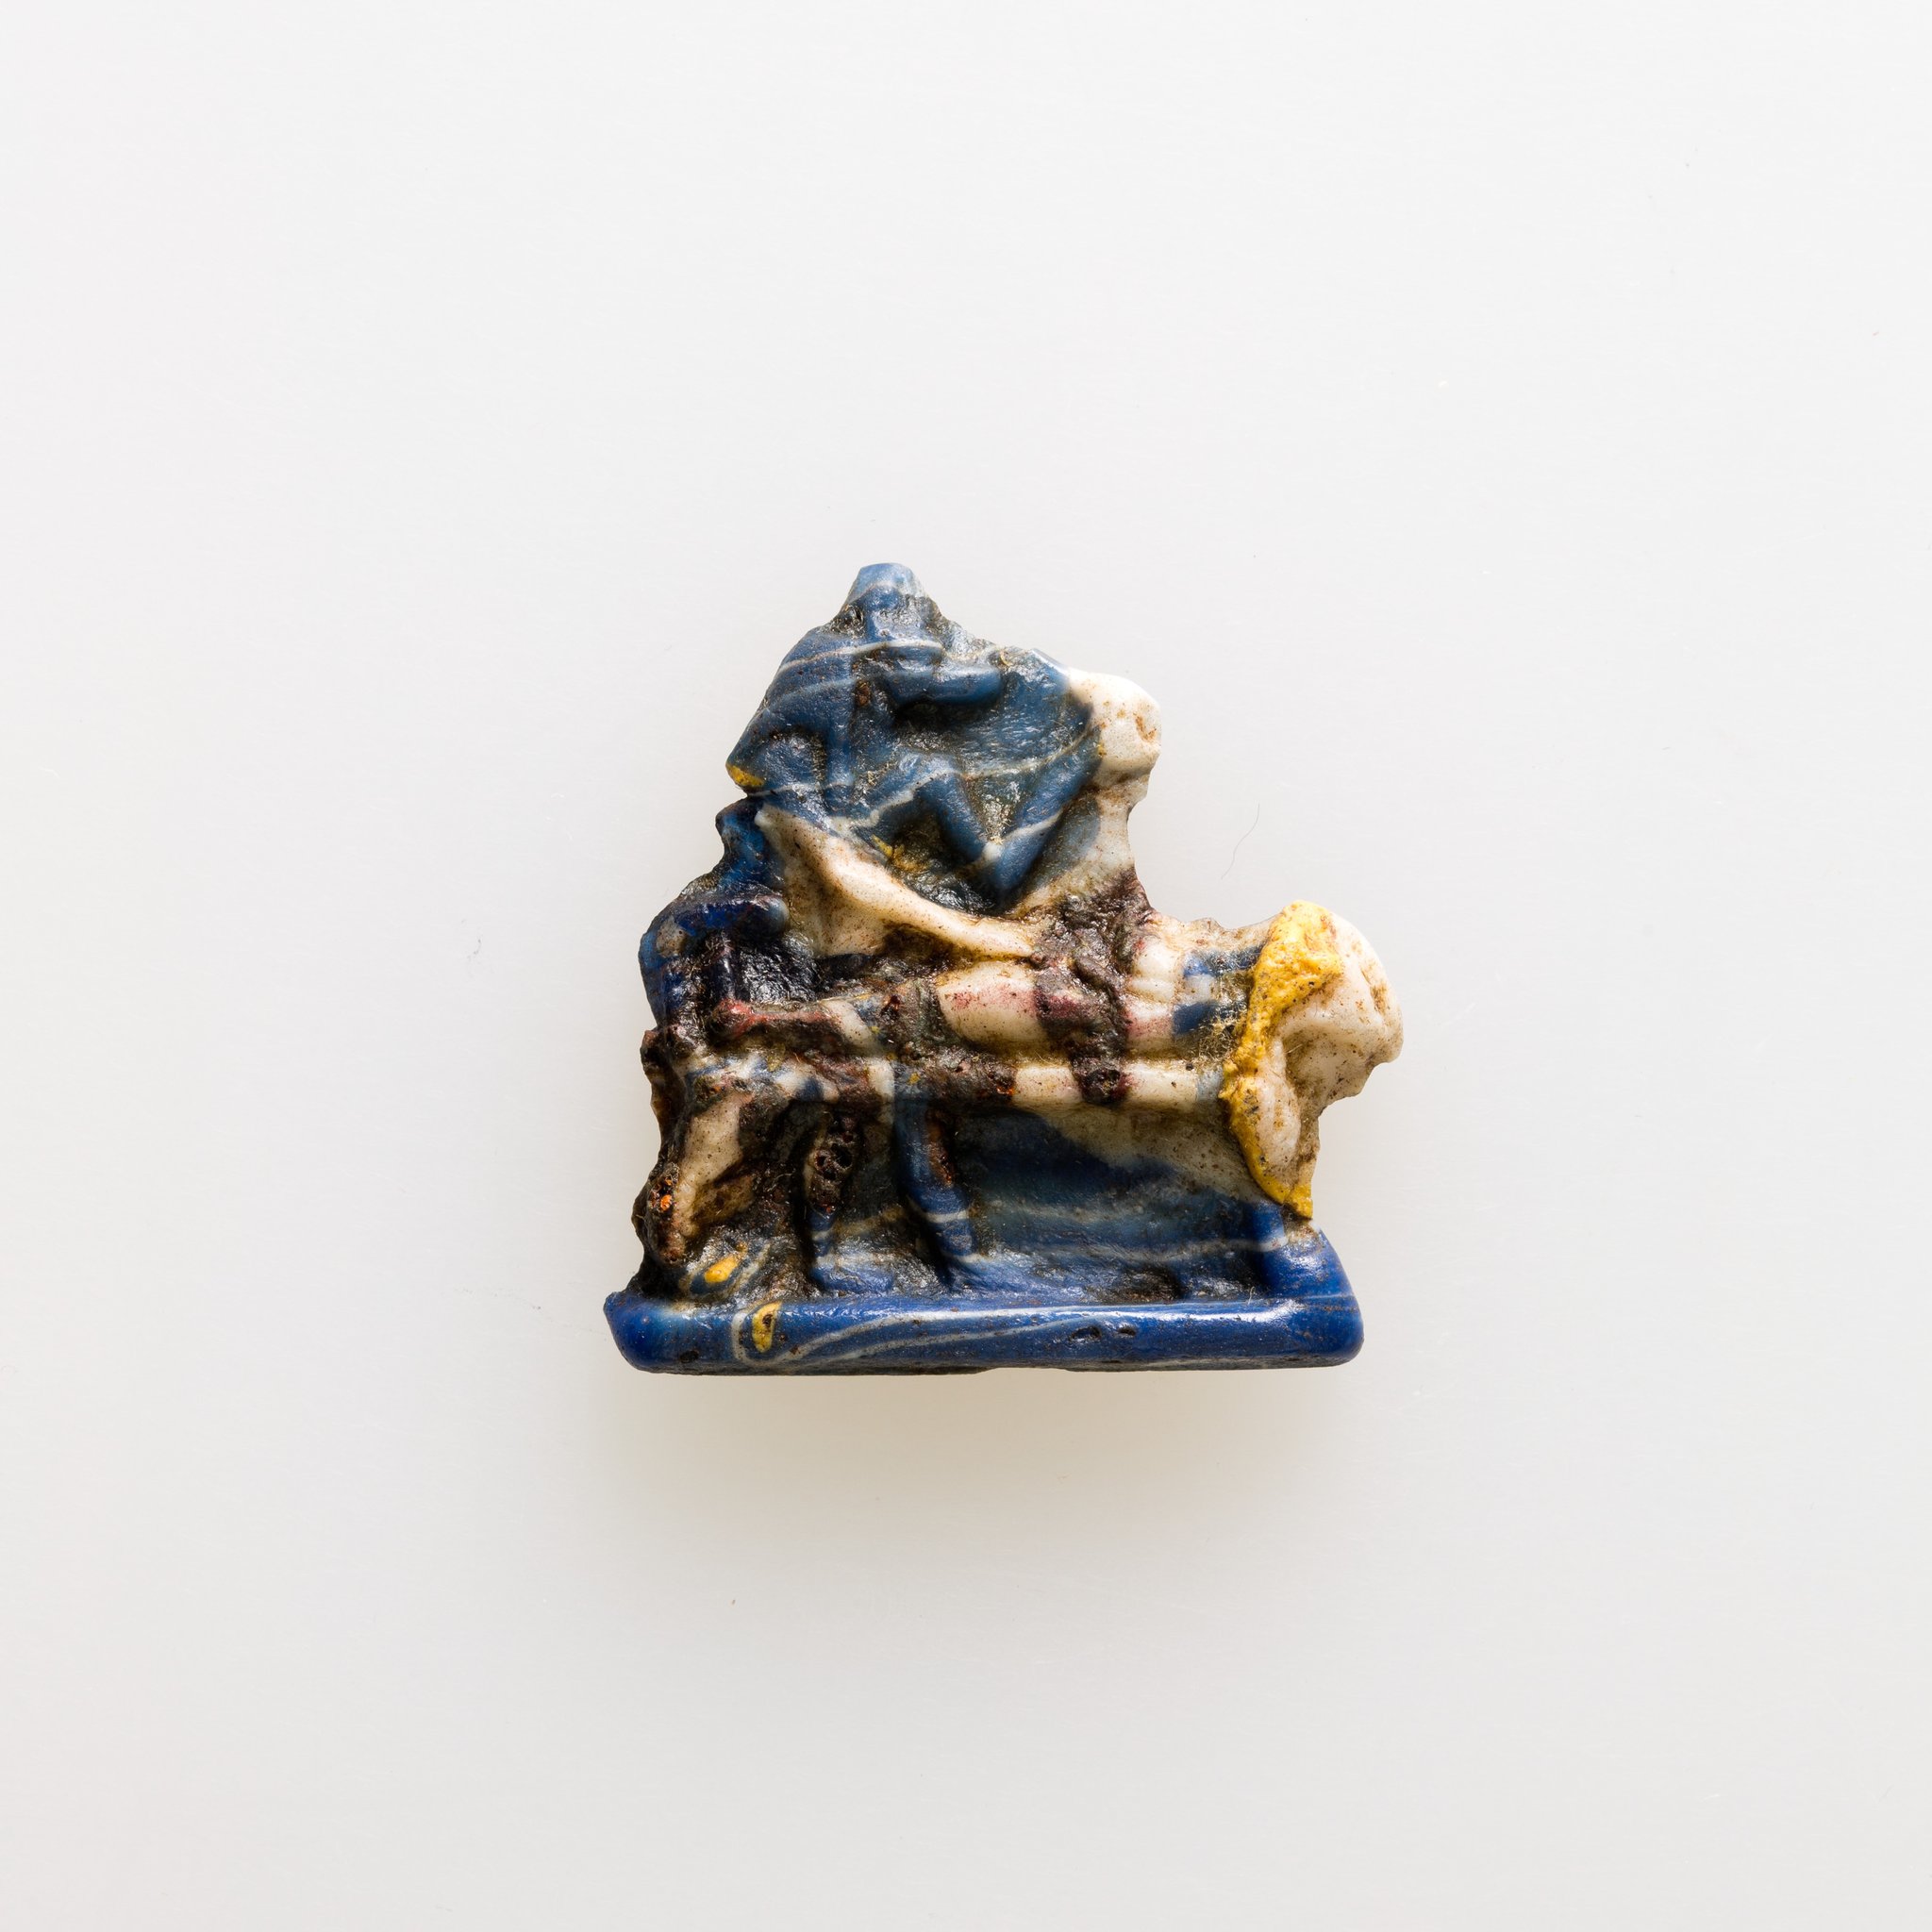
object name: amulet, anubis, bier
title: Amulet showing Anubis standing over mummy on bier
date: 332-330 BCE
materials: glass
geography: egypt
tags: anubis,mummies